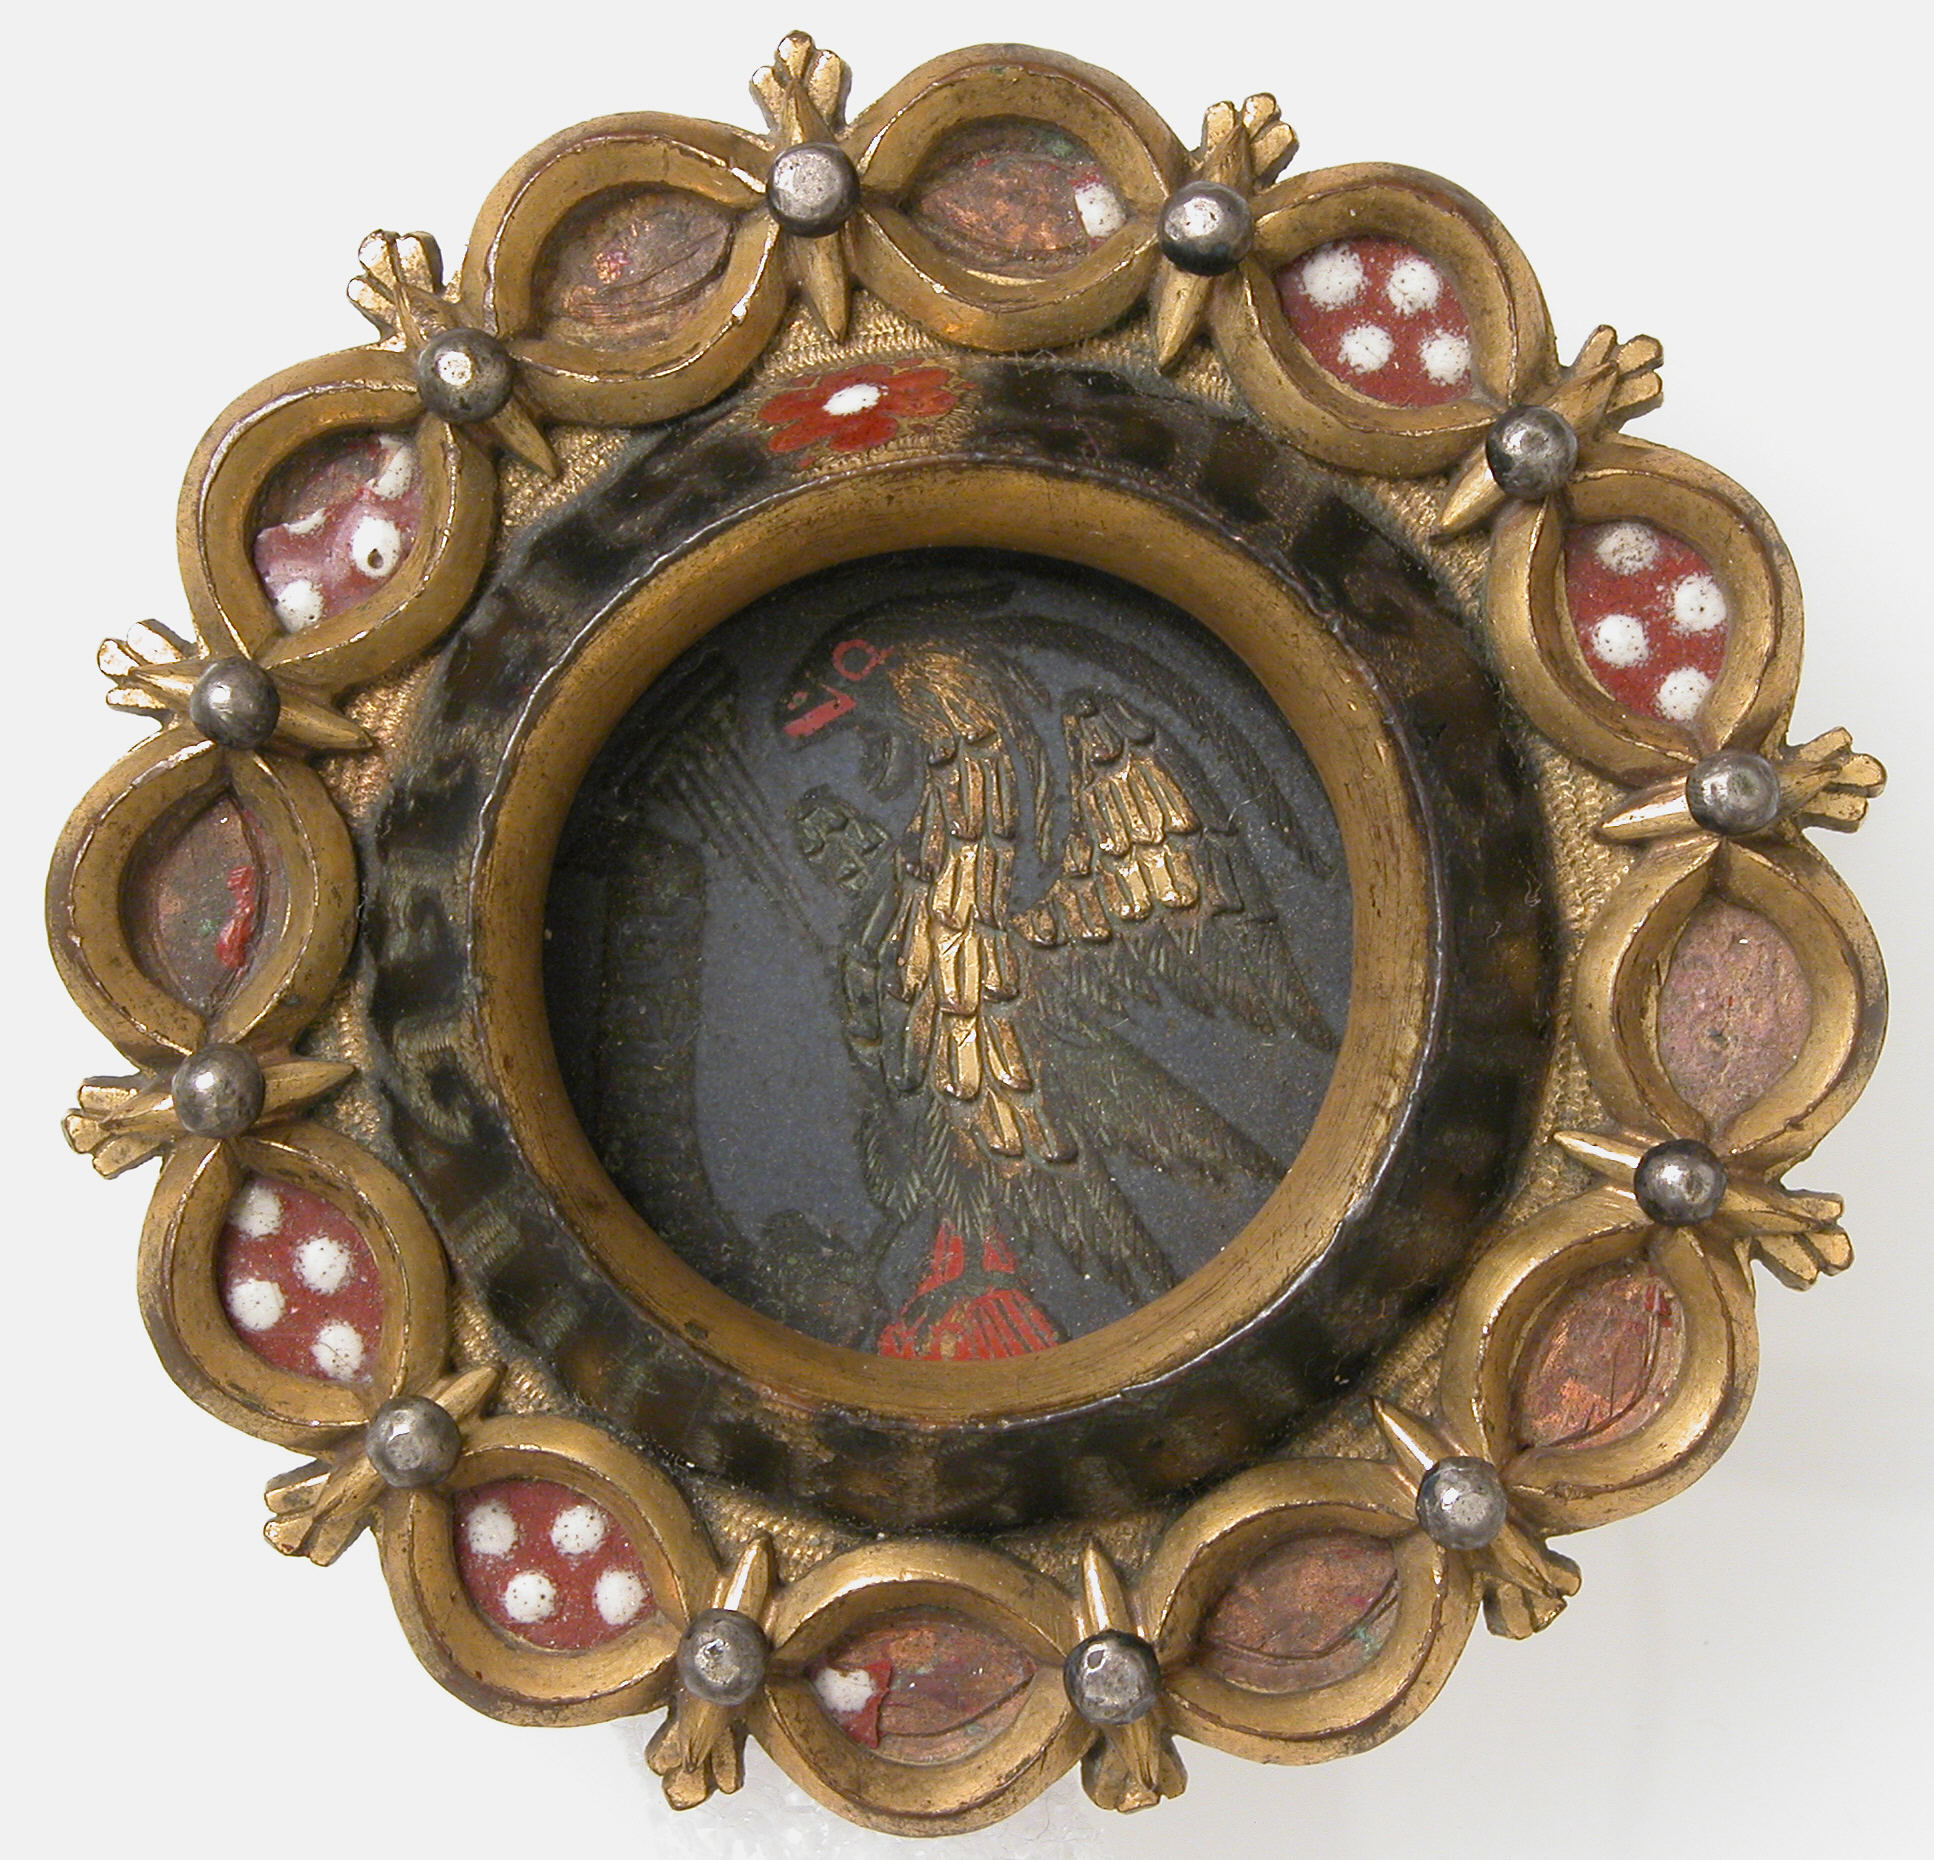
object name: ornament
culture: french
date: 1401-1500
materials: copper, enamel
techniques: enamel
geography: france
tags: eagles